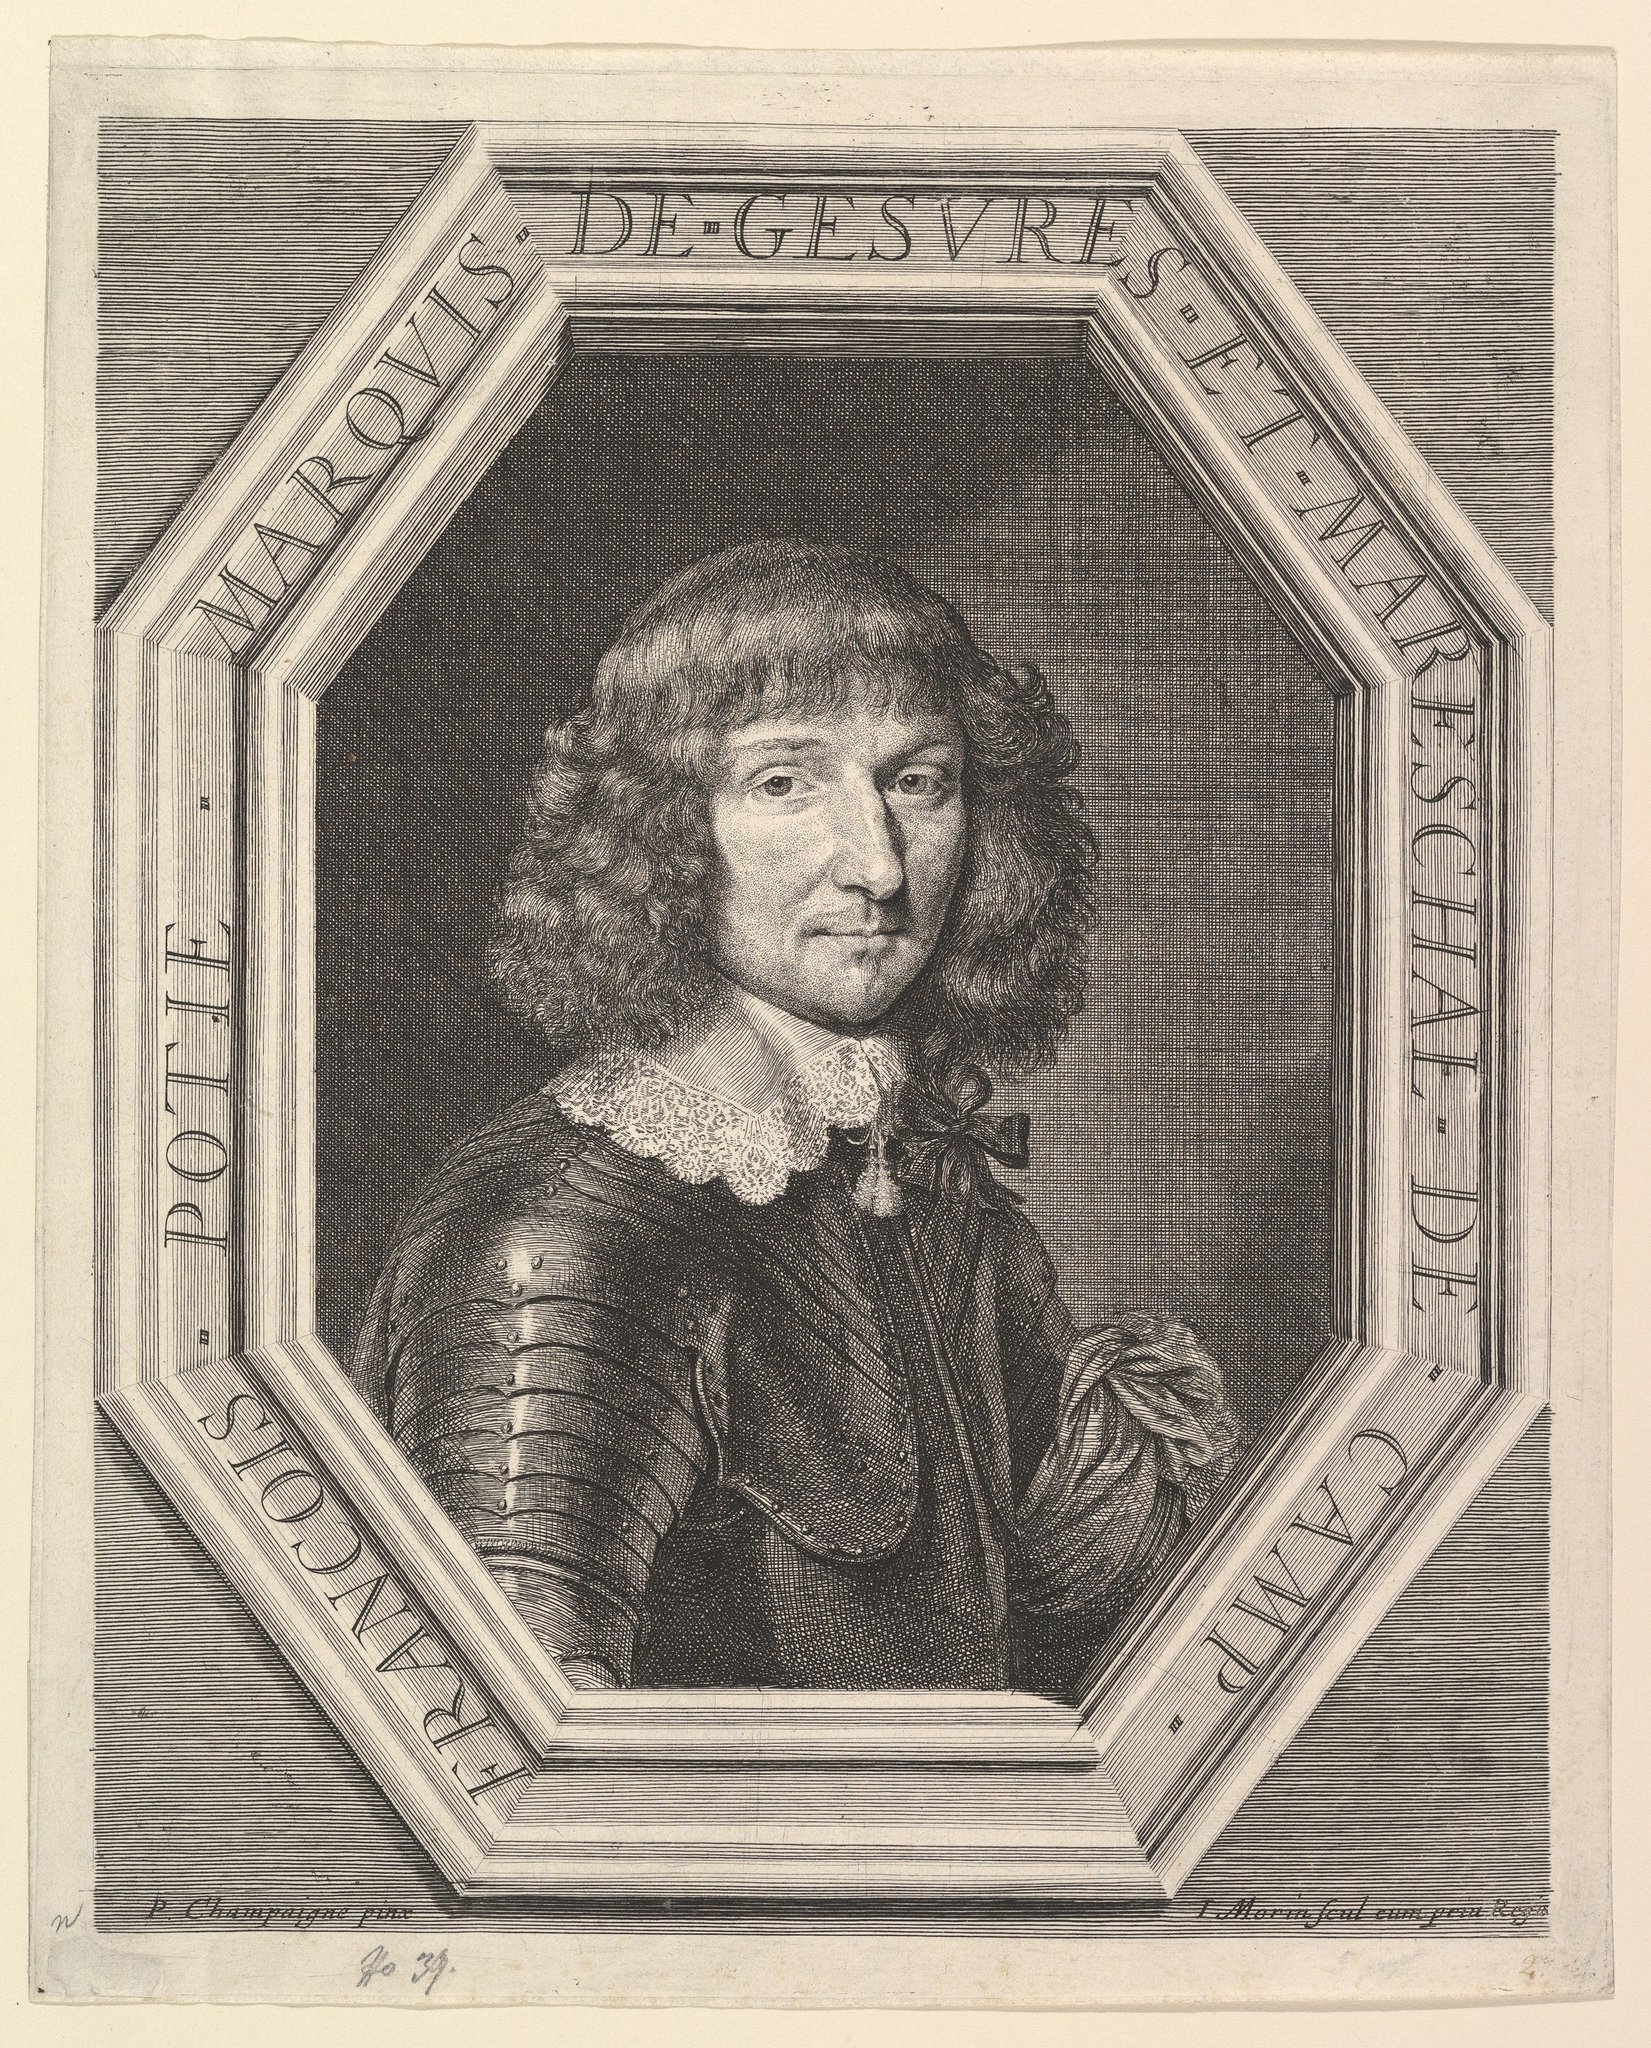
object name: print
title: Francois Potier, marquis de Gesvres, marechal de camp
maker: jean morin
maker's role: artist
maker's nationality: french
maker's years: 1605-1650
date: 1605-1650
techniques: etching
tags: men,portraits